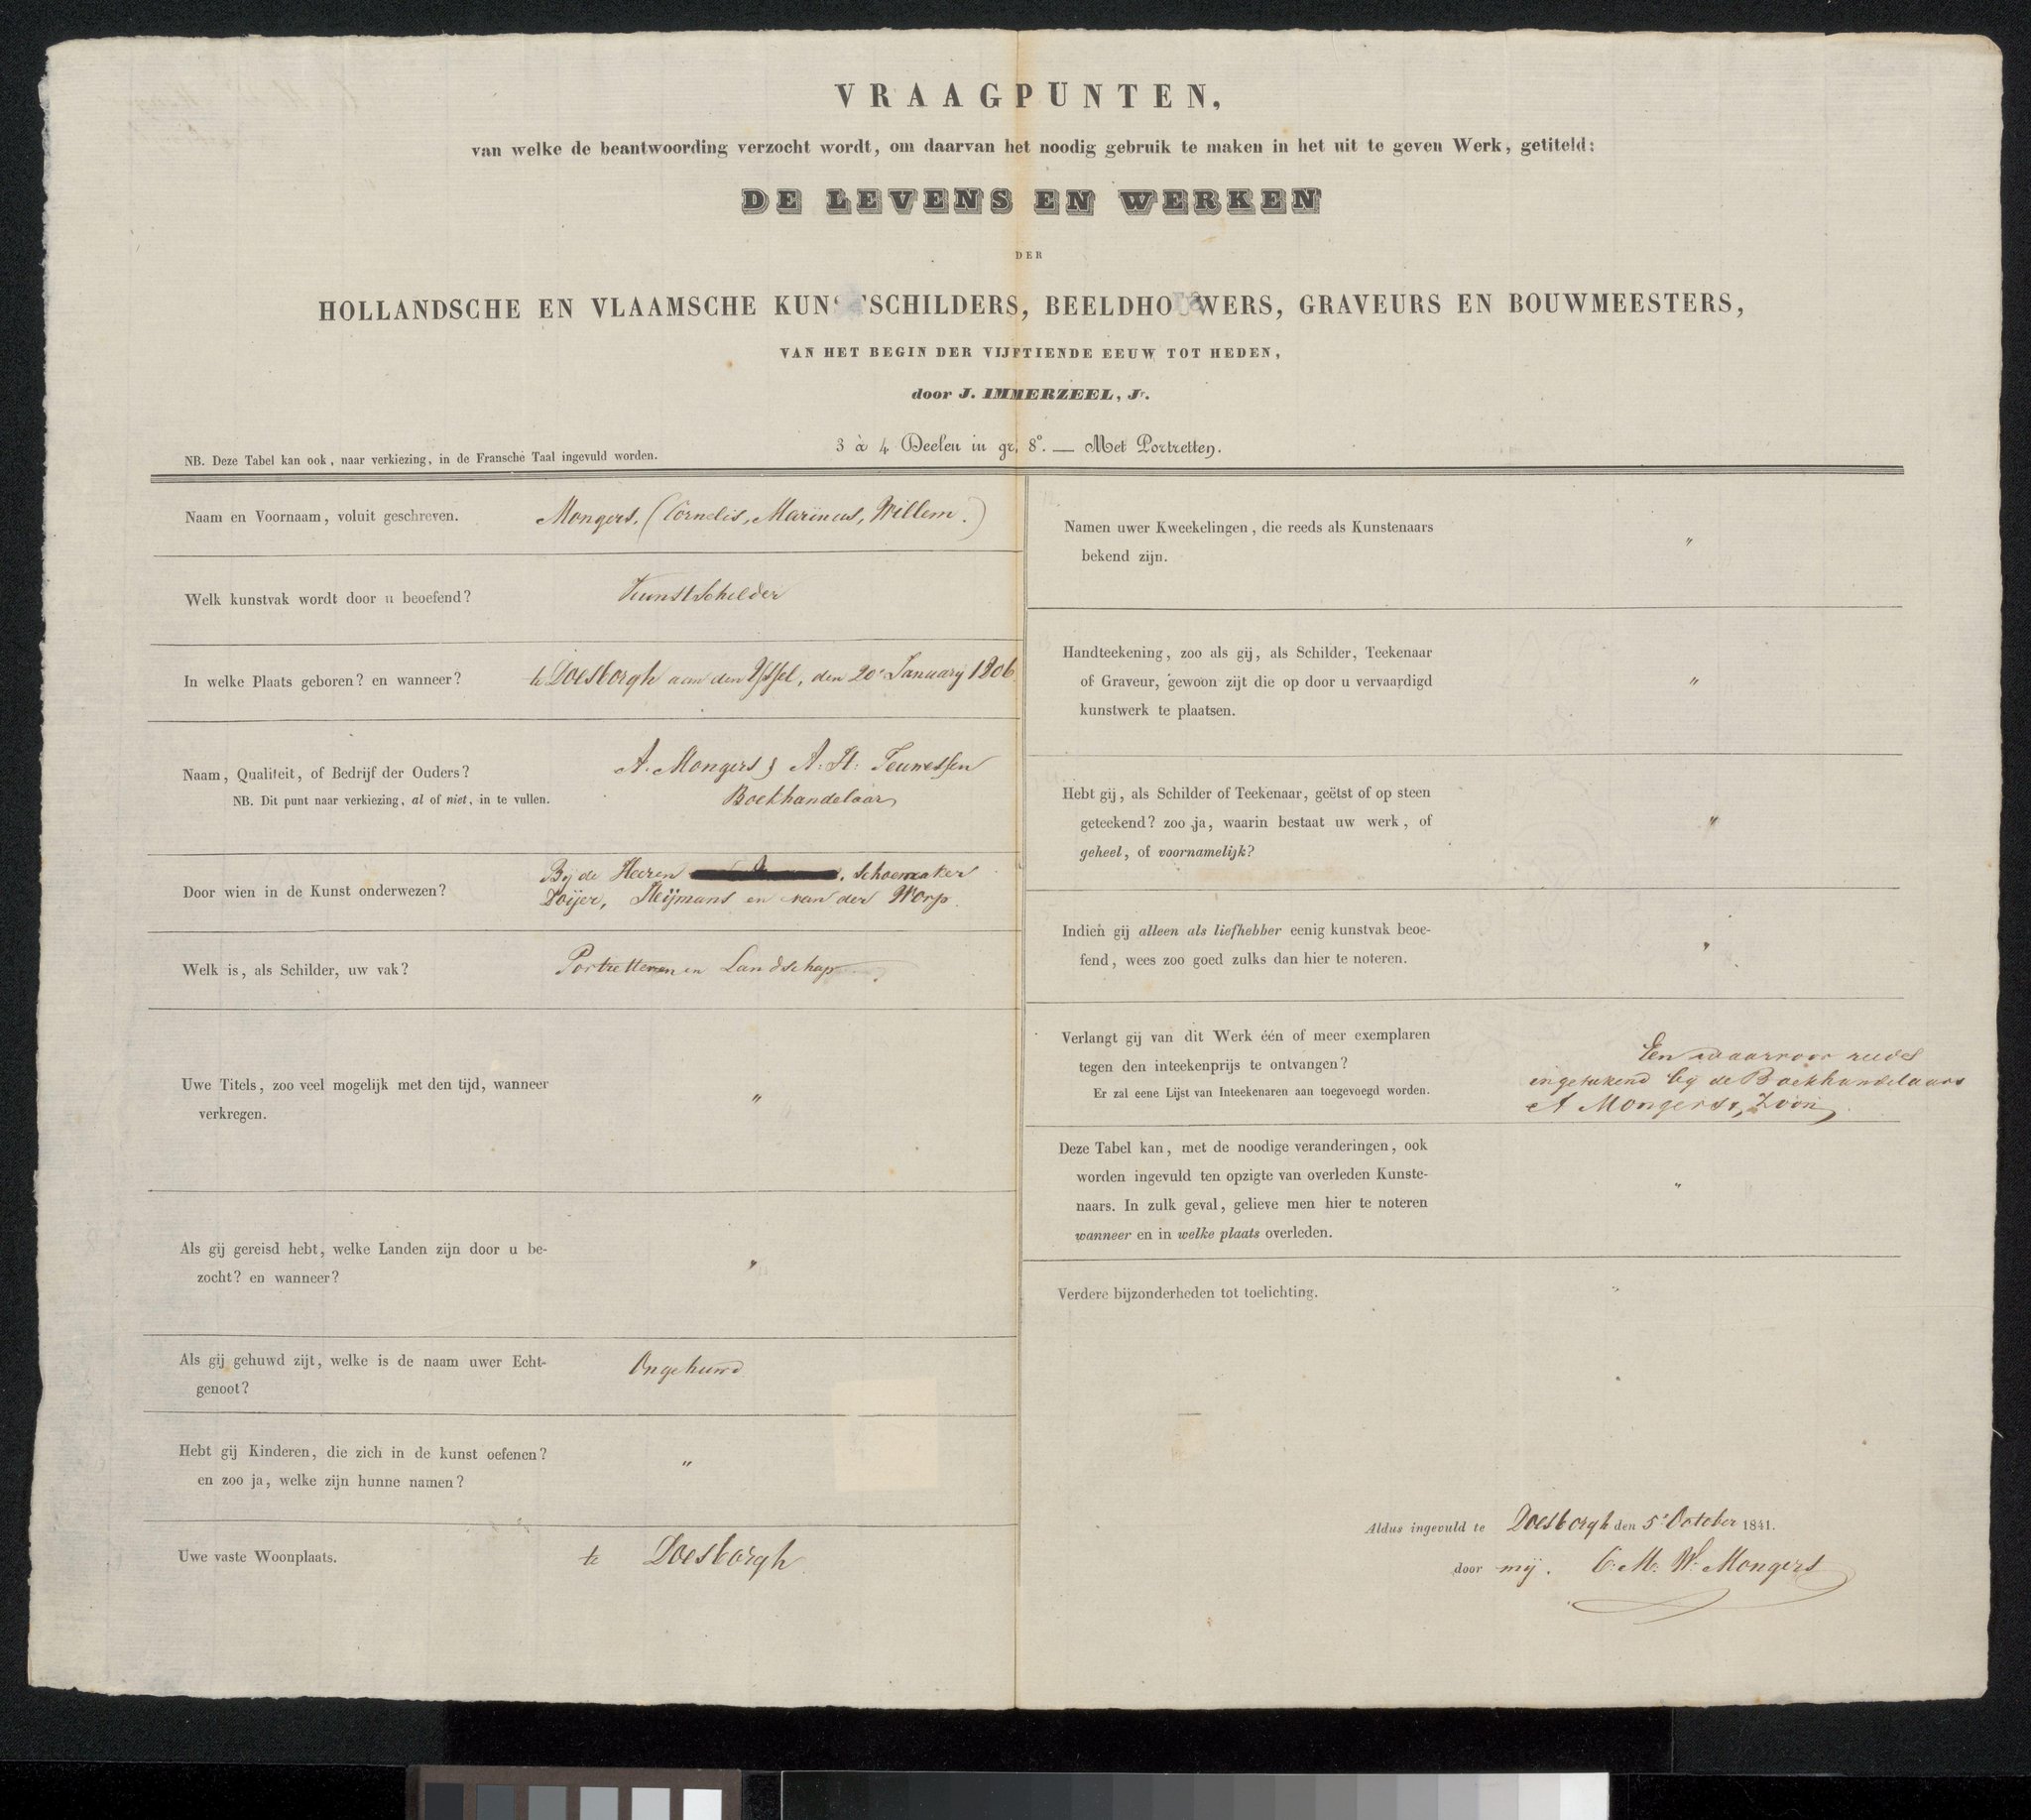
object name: questionnaire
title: Enquêteformulier ingevuld door Cornelis Marinus Willem Mongers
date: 1841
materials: ink, paper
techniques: pen, printing, writing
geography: doesburg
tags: painter, cornelis marinus willem mongers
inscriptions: watermark, inscription: ‘Vraagpunten,/ van welke de beantwoording verzocht wordt, om daarvan het noodig gebruik te maken in het uit te geven Werk, getiteld: De levens en werken/ der Hollandsche en Vlaamsche kunstschilders, beeldhouwers,/ graveurs en bouwmeesters, van het begin der vijftiende eeuw tot heden/ door J. Immerzeel, Jr.’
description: Opgenomen in: Immerzeel, J. Jr., De levens en werken der Hollandsche en Vlaamsche kunstschilders, beeldhouwers, graveurs en bouwmeesters, van het begin der vijftiende eeuw tot heden, Amsterdam: J.C. van Kesteren, 1842-1843.